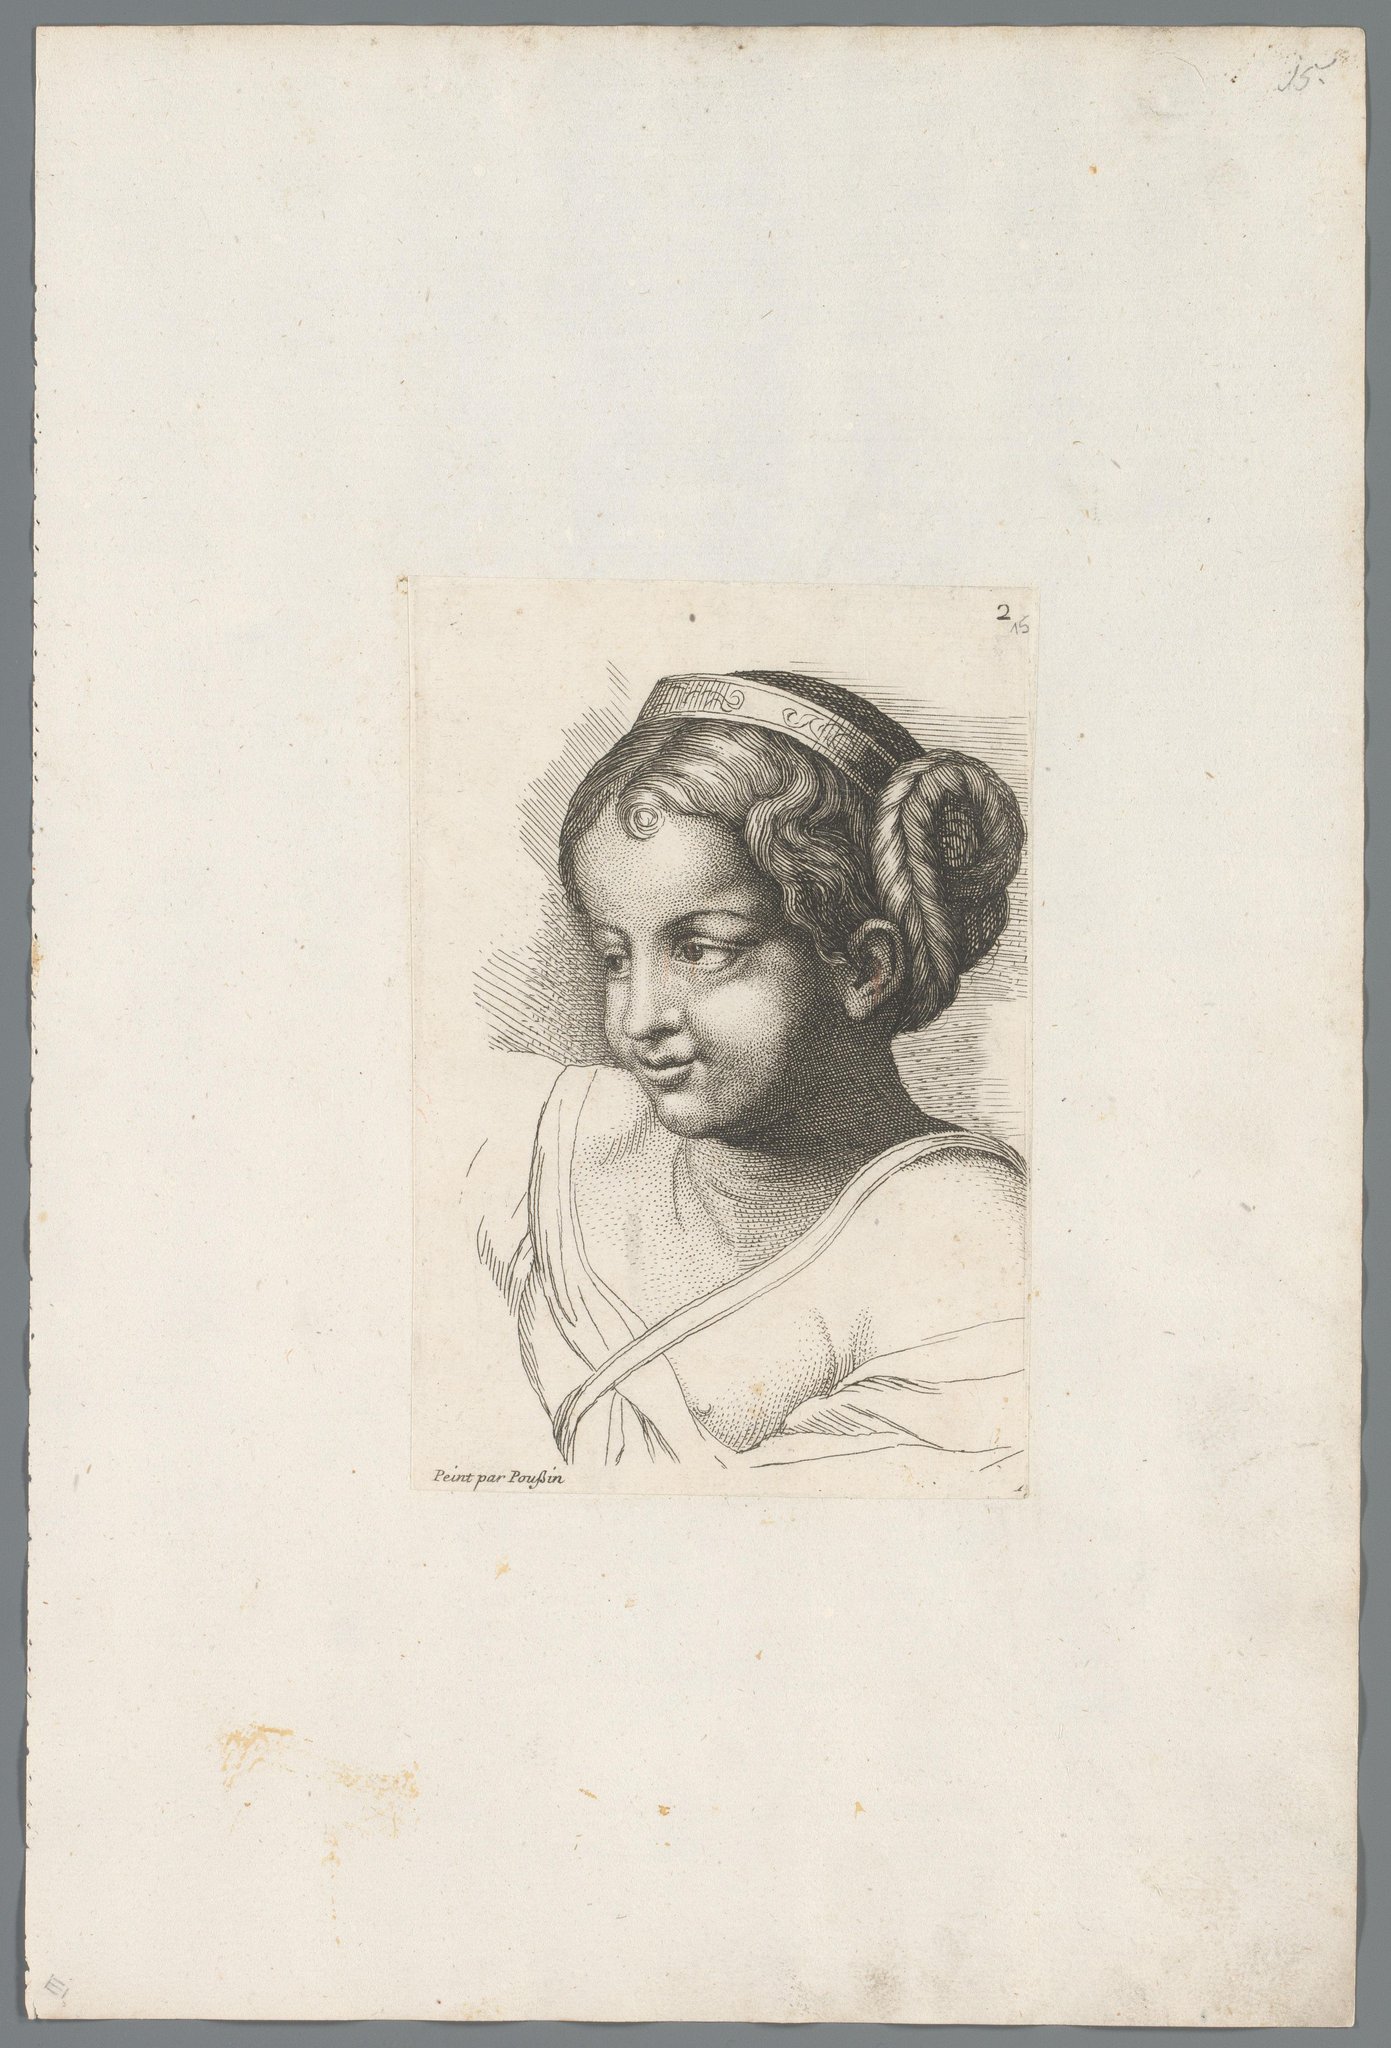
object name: print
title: Portret van een onbekende vrouw met vlecht en haarband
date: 1650-1703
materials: paper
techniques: engraving, etching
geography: paris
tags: anonymous historical person portrayed - bb - woman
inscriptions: collector's mark: Lugt 2760, collector's mark: Lugt 2228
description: Prent uit een serie met op elke prent een hoofd uit een schilderij van Poussin.